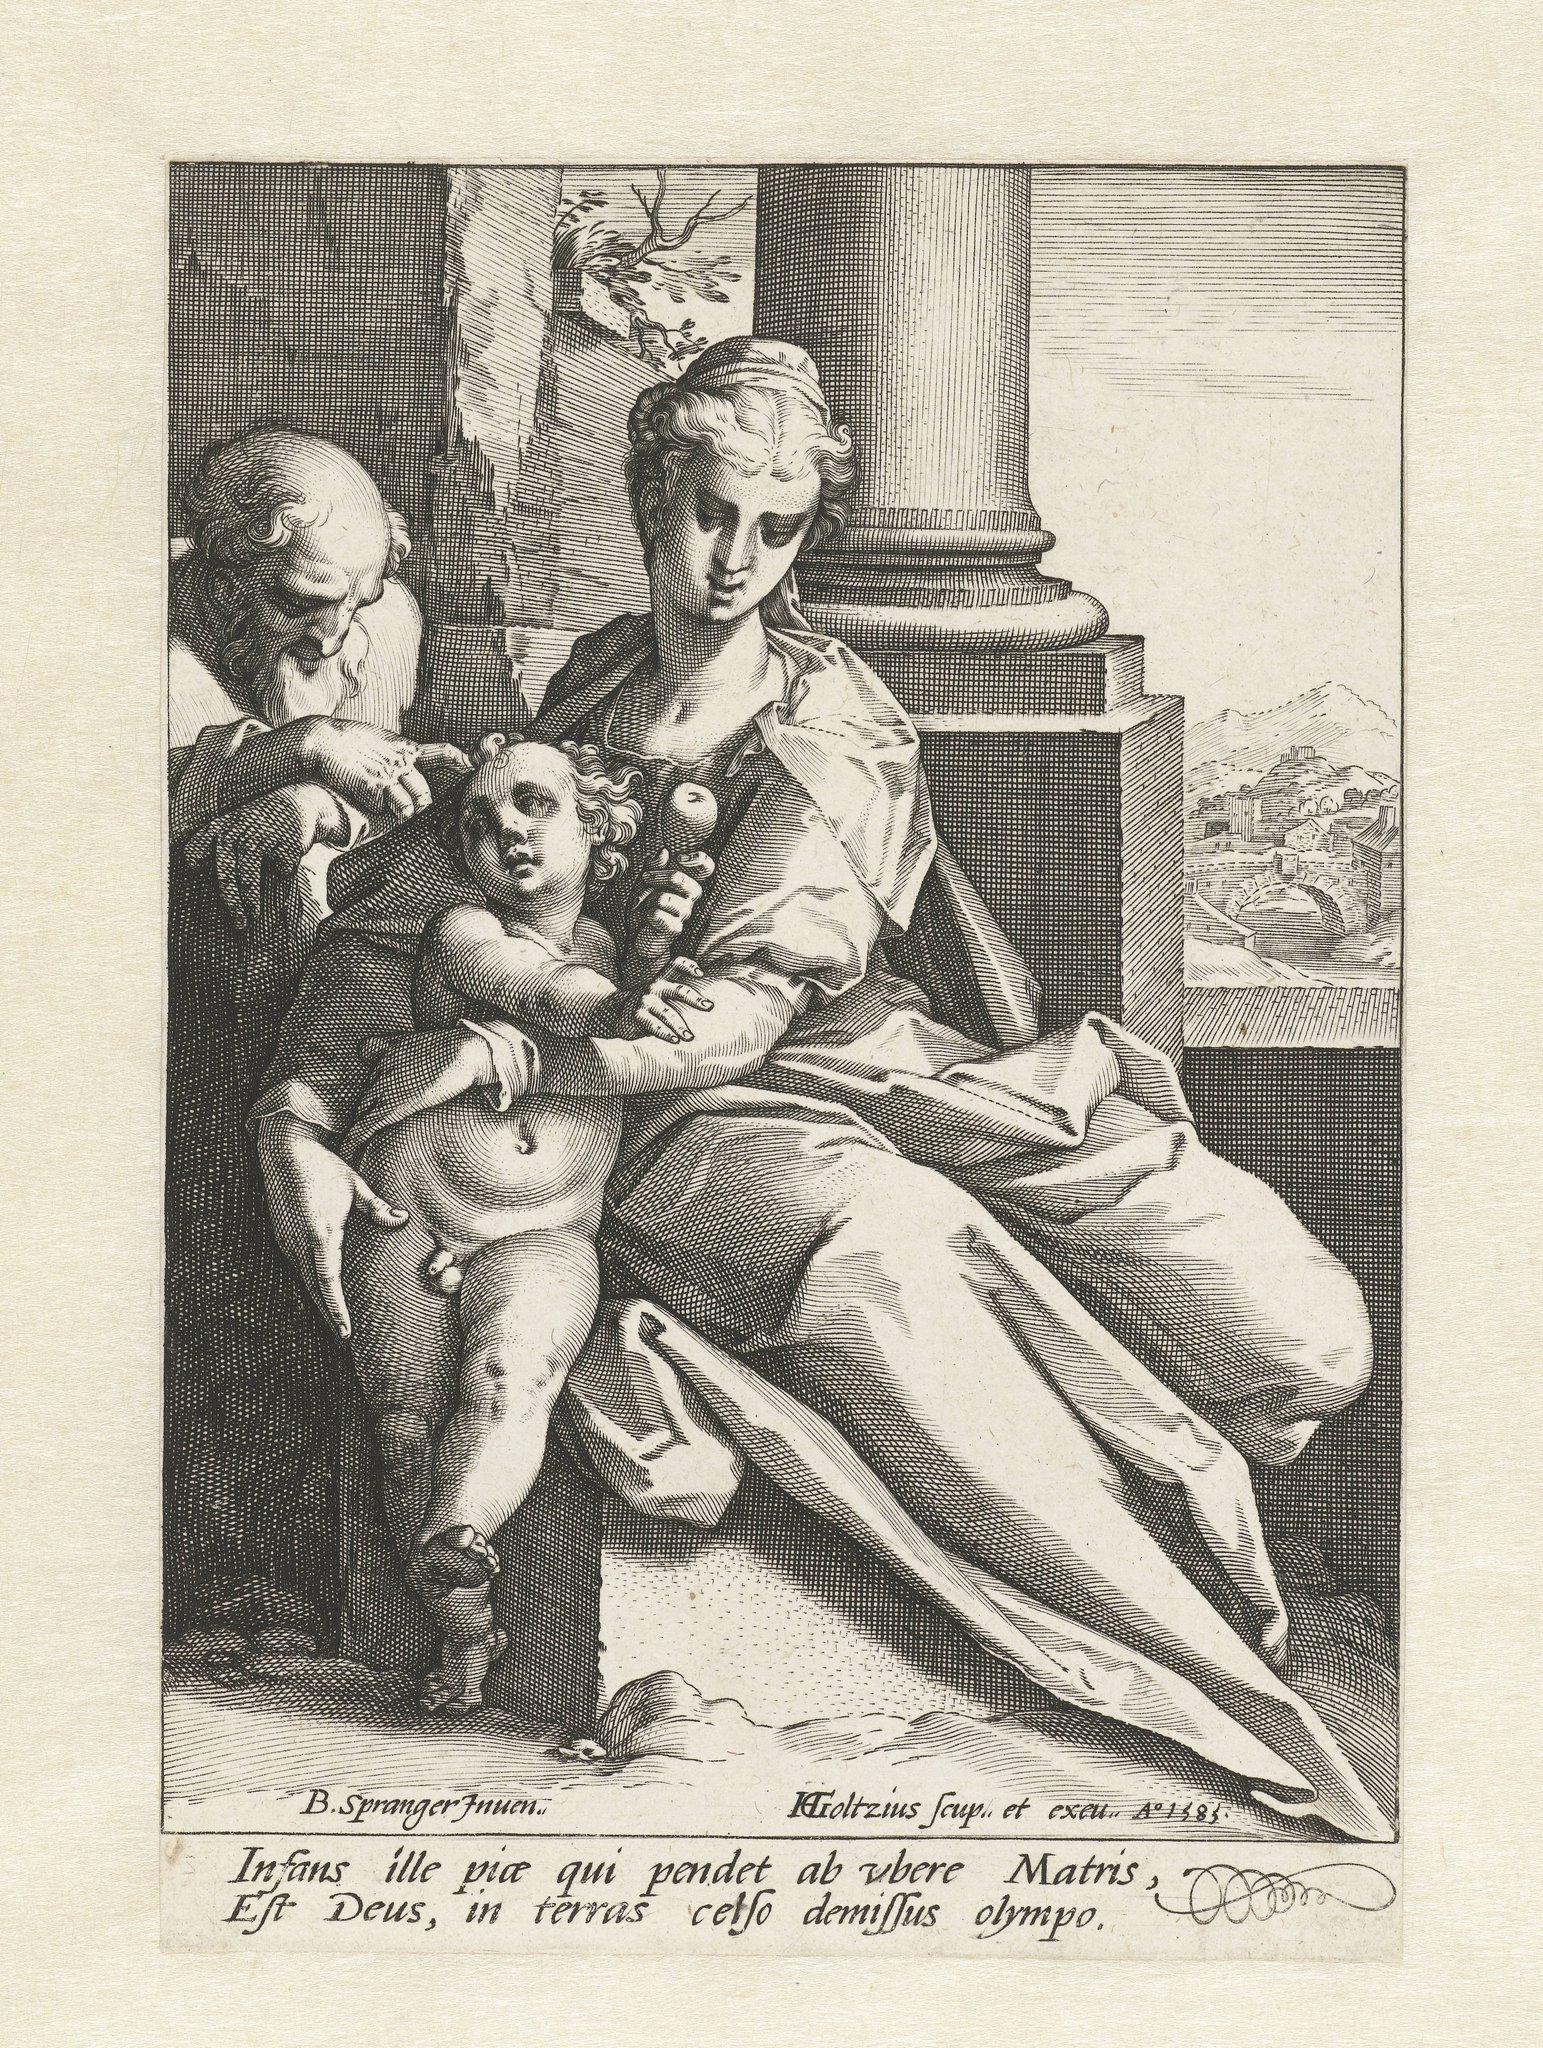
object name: print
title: The Holy Family before a Column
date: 1585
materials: paper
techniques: engraving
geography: haarlem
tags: holy family (alone), 'trinitas terrestris'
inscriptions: date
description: Maria, Jozef en het Christuskind, allen ten voeten uit, bij een zuil. Christus houdt een appel in de linkerhand. Onder de voorstelling twee regels Latijnse tekst.